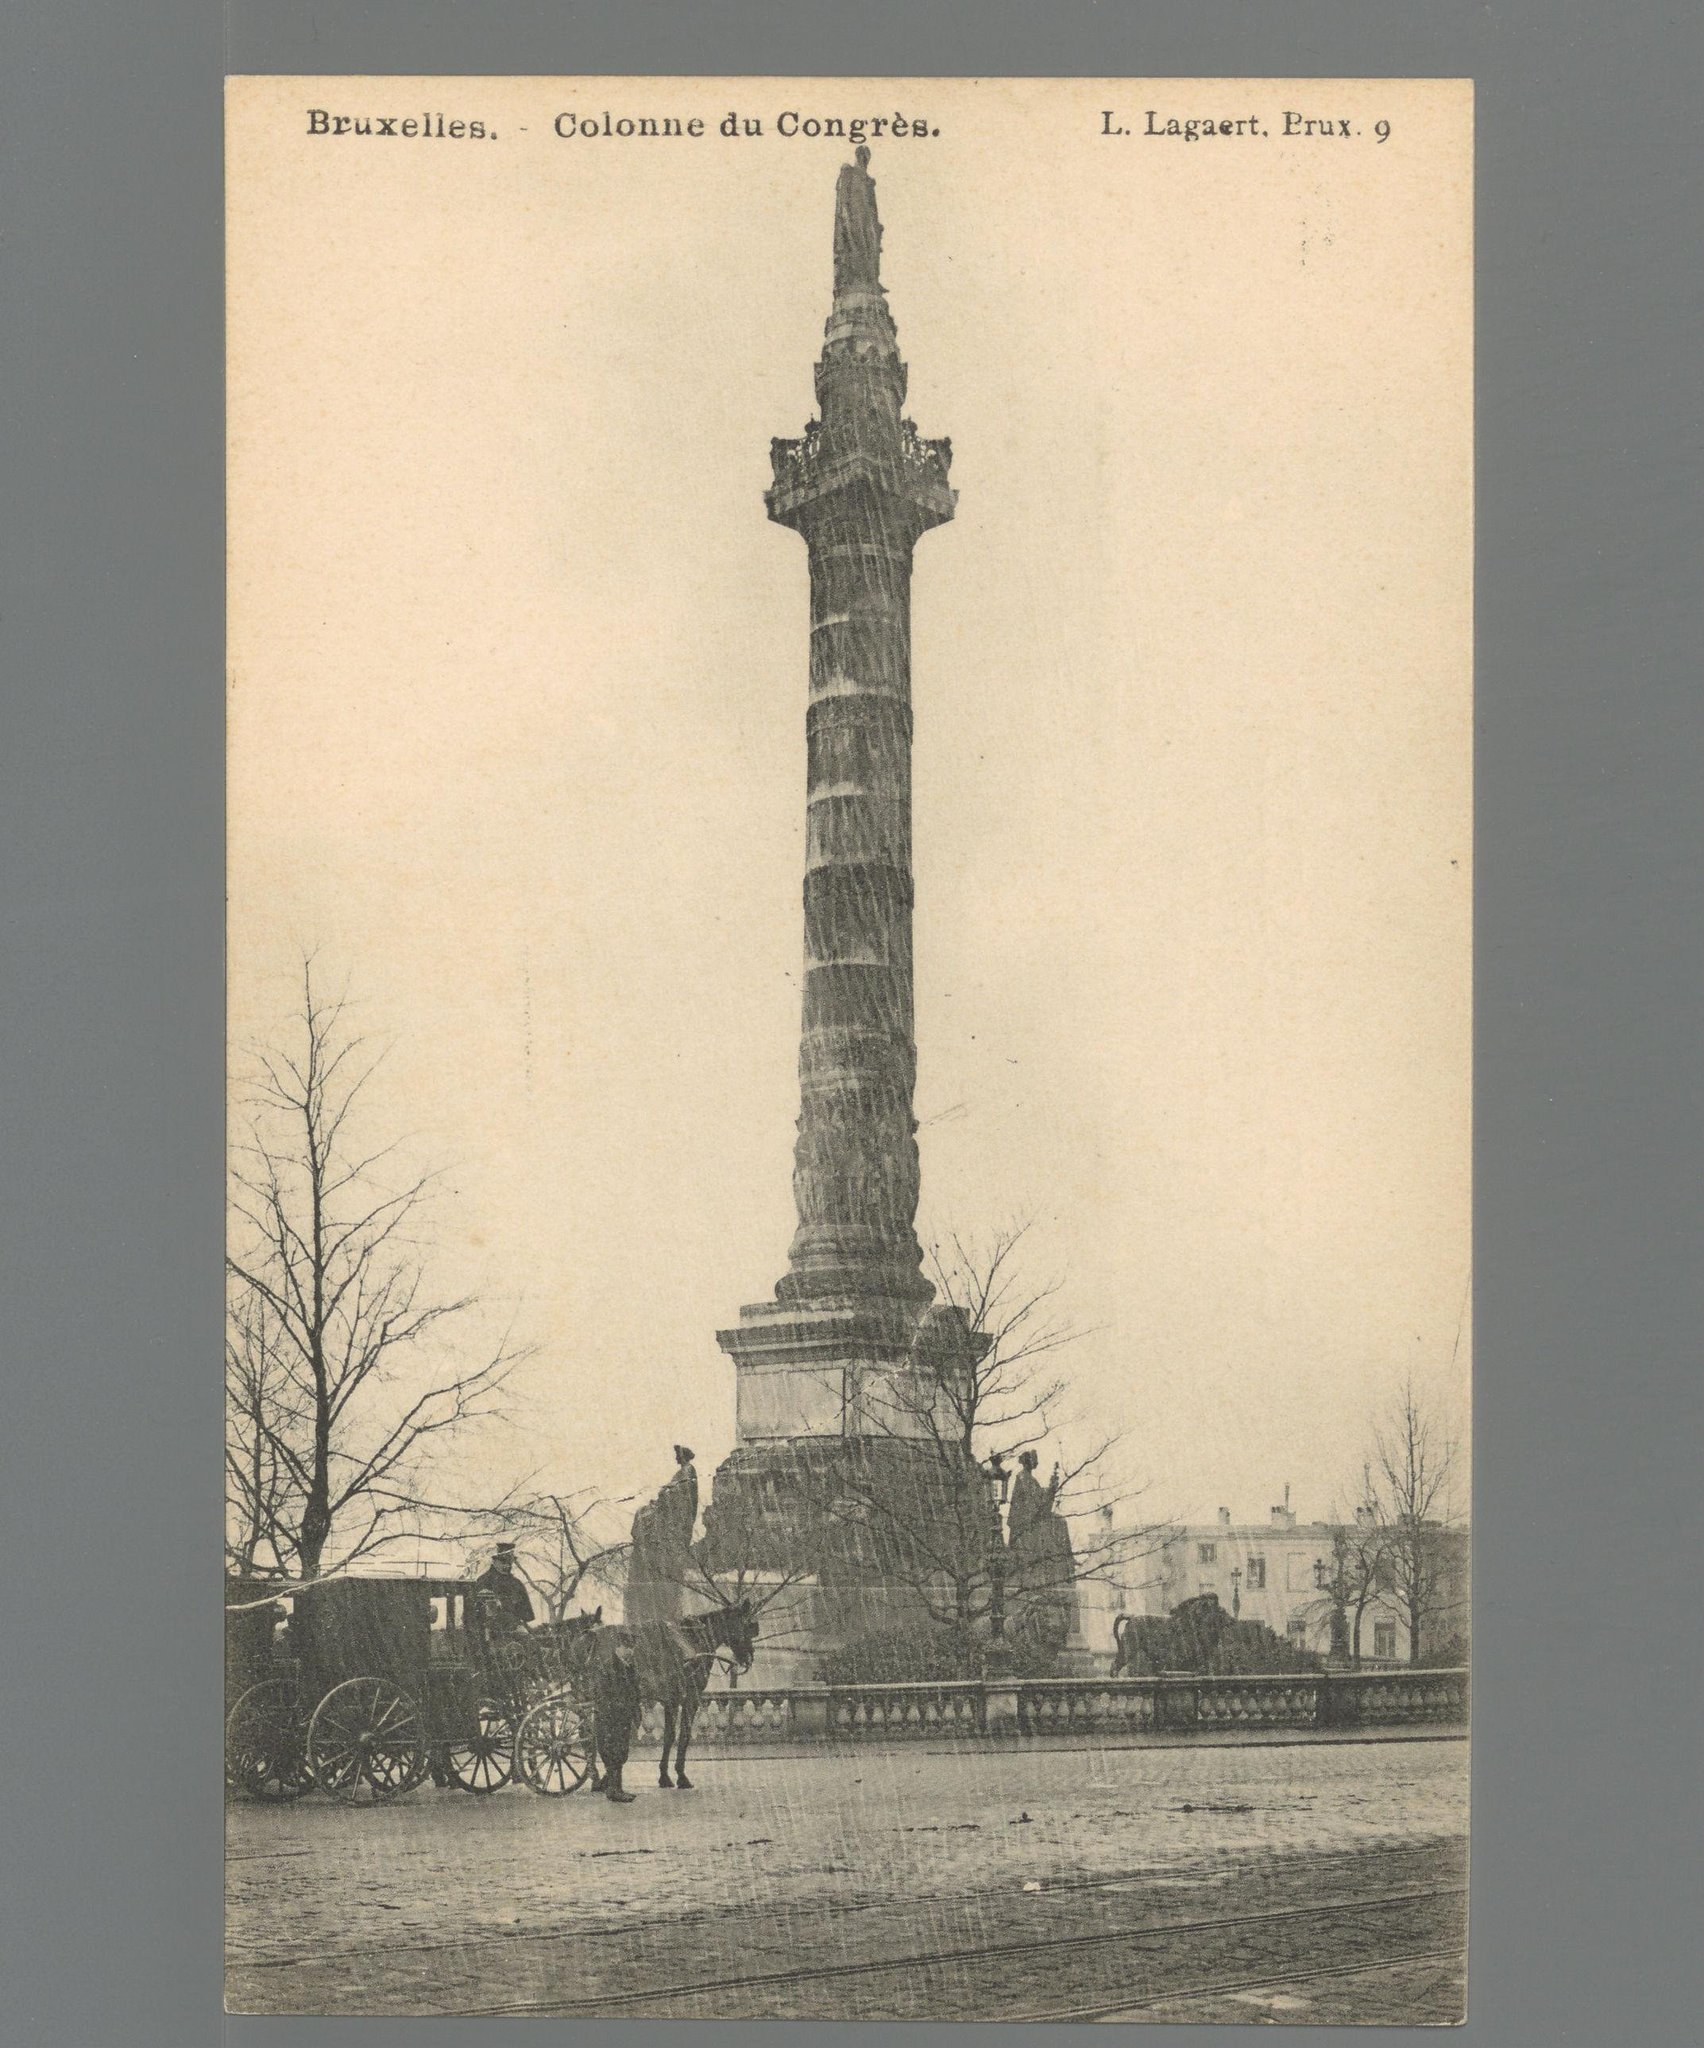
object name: photomechanical print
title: Brux.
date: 1906-1913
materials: cardboard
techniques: photograph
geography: schaarbeek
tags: monument, statue, city-view, and landscape with man-made constructions (+ city(-scape) with figures, staffage)